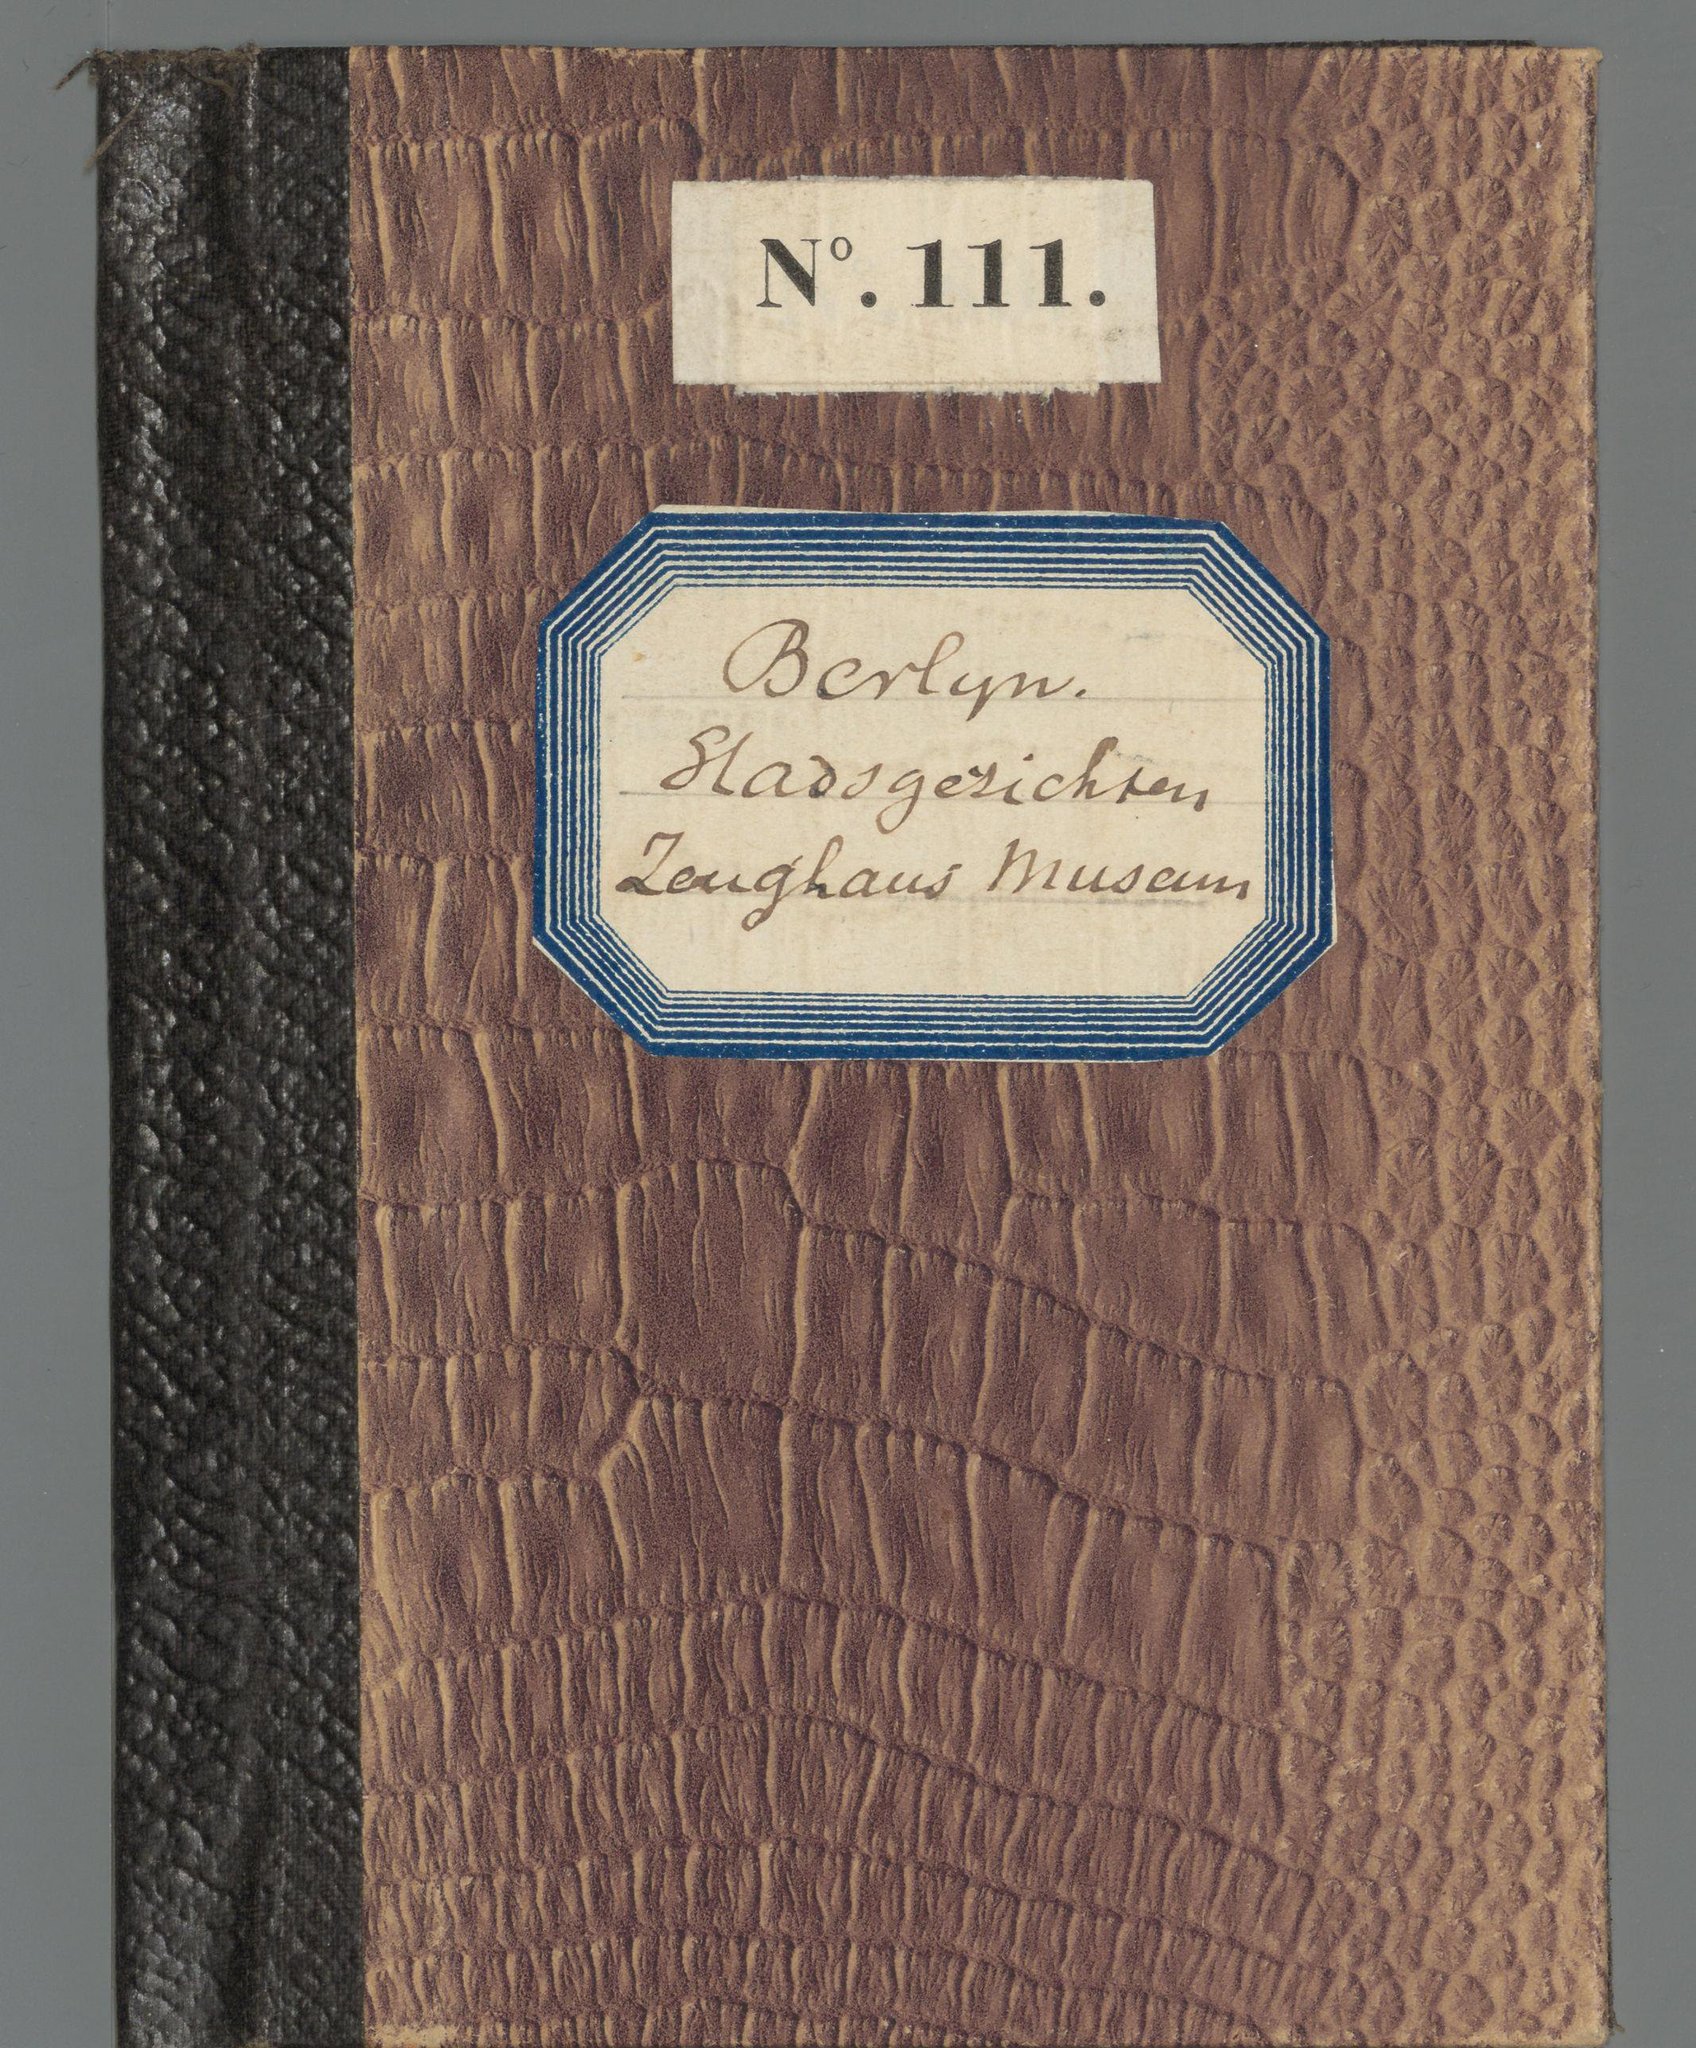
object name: wrapper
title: Berlijn. Stadsgezichten, Zeughaus Museum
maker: Anonymous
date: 1900-1950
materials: cardboard, paper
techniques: lithograph, writing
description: In de omslag zit een kaart ingestoken met daarop een korte beschrijving van de inhoud.